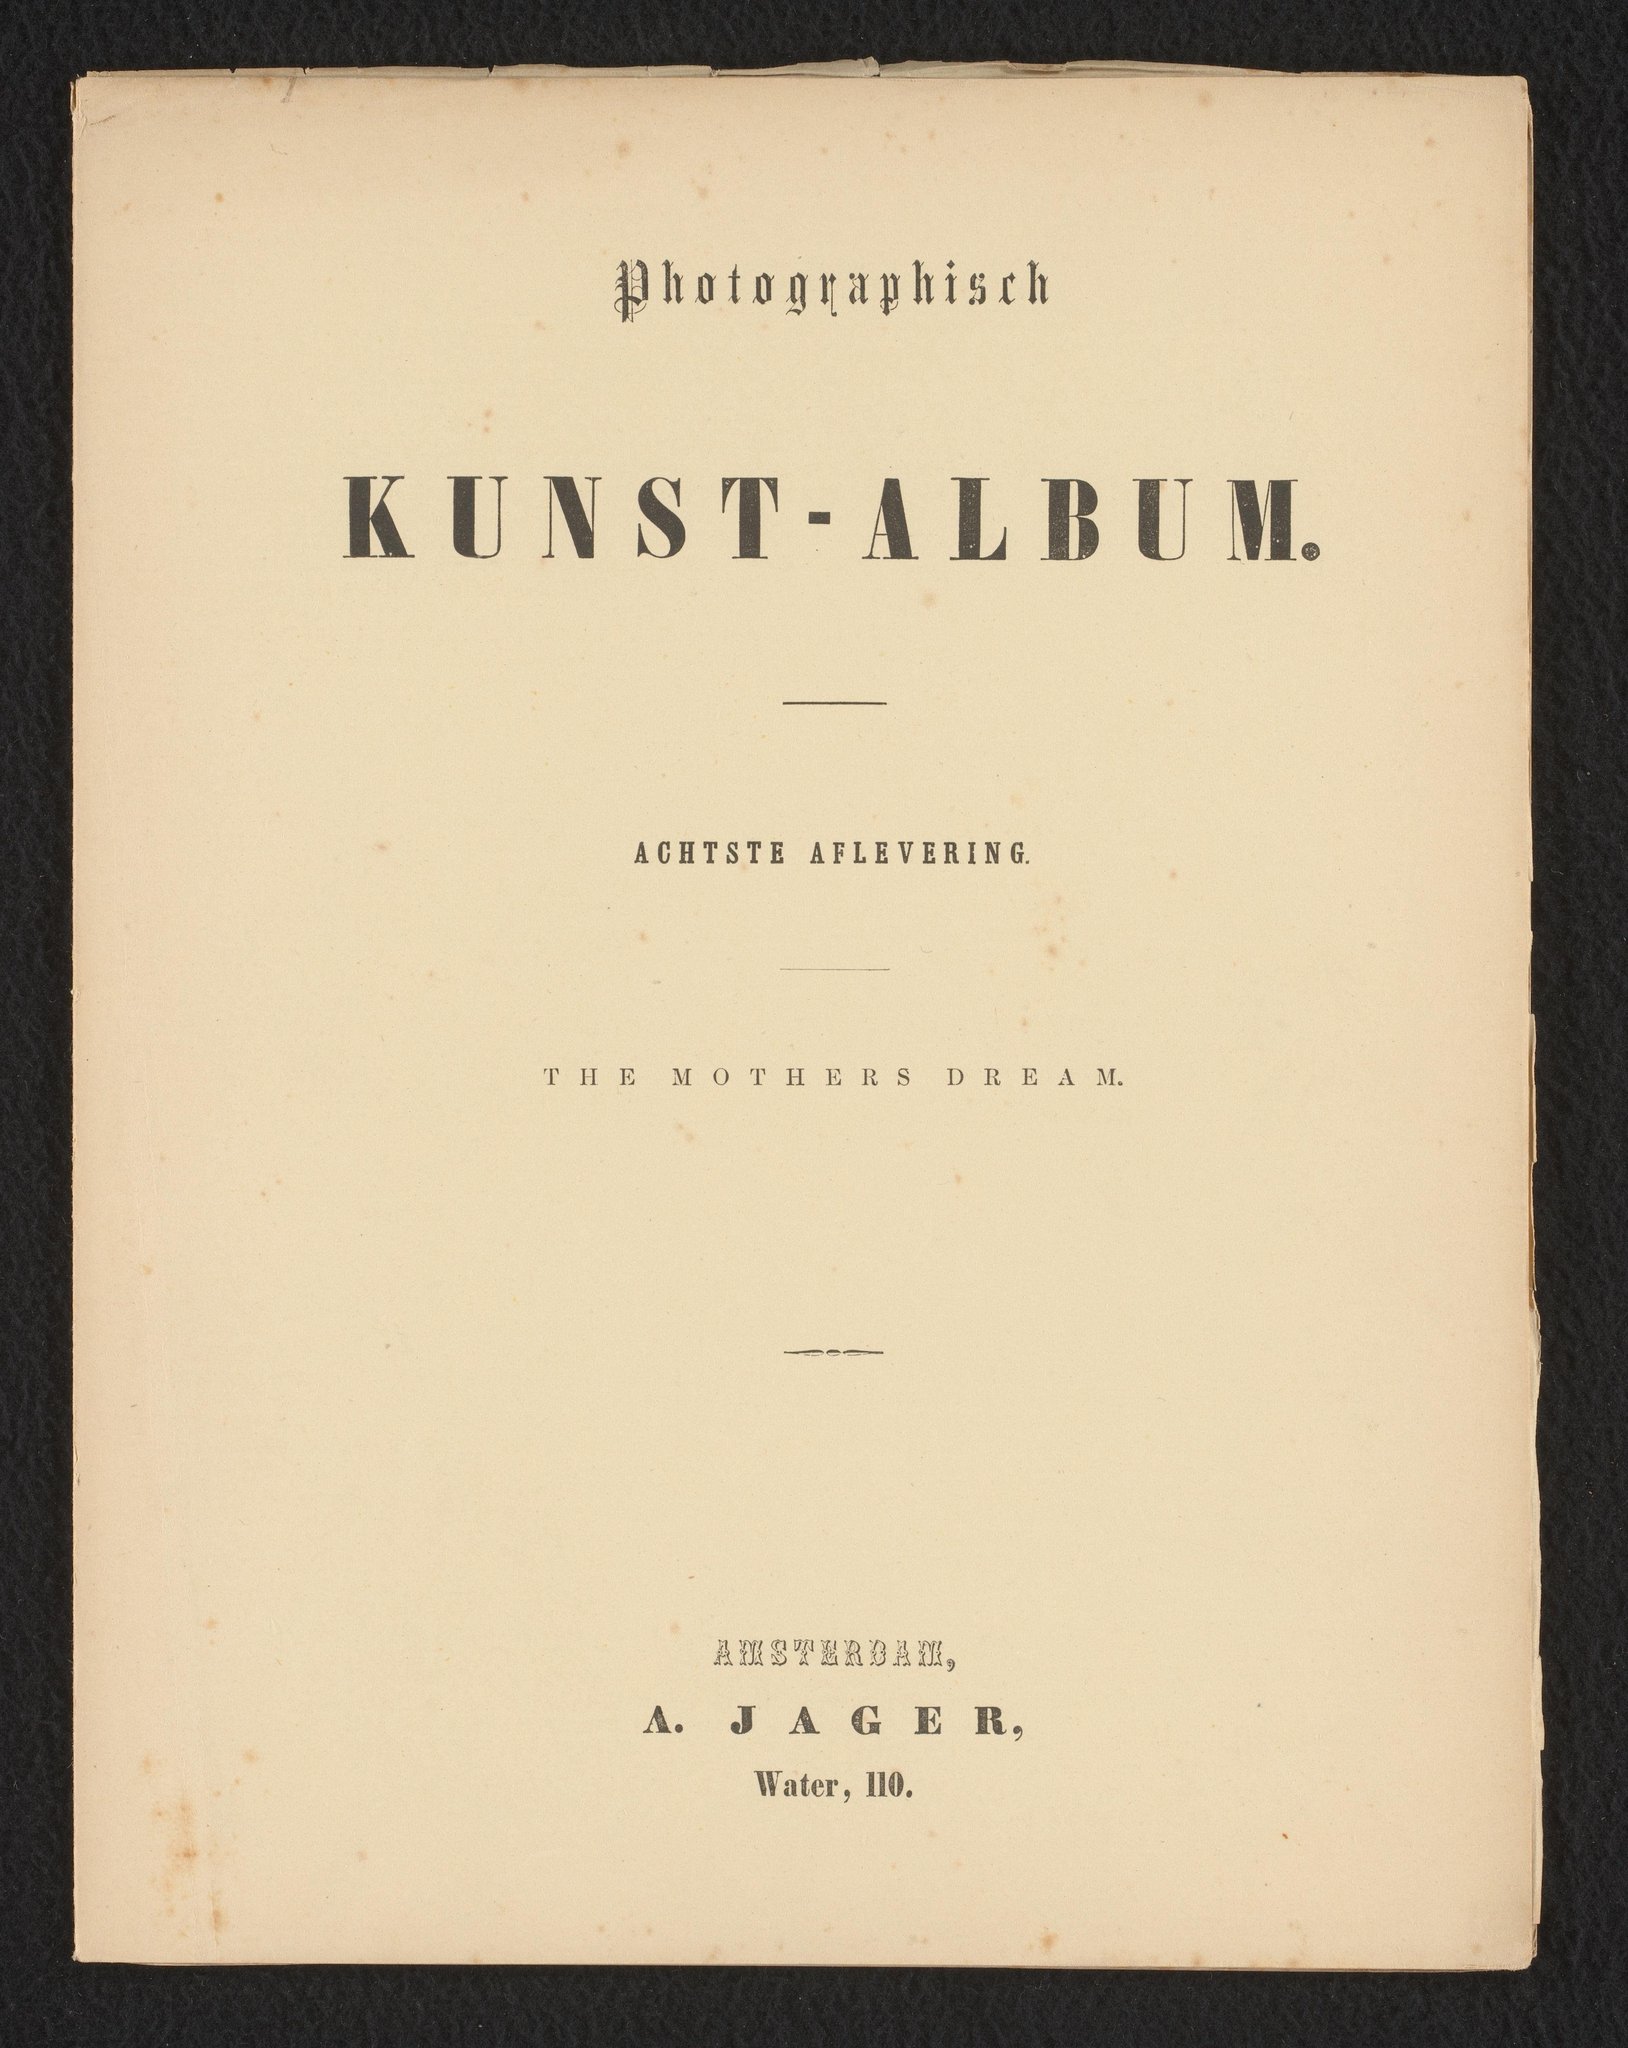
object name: wrapper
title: Achtste aflevering. The Mothers Dream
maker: andries jager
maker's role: publisher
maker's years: 1825-1905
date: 1860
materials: paper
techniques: printing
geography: amsterdam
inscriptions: inscription: ‘THE MOTHERS DREAM./ NAAR EENE SCHILDERIJ/ VAN/ THOMAS BROOKS.’, address: ‘AMSTERDAM,/ A. JAGER,/ Water, 110.’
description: Deze omslag maakt deel uit van een omslag met twaalf fotoreproducties.